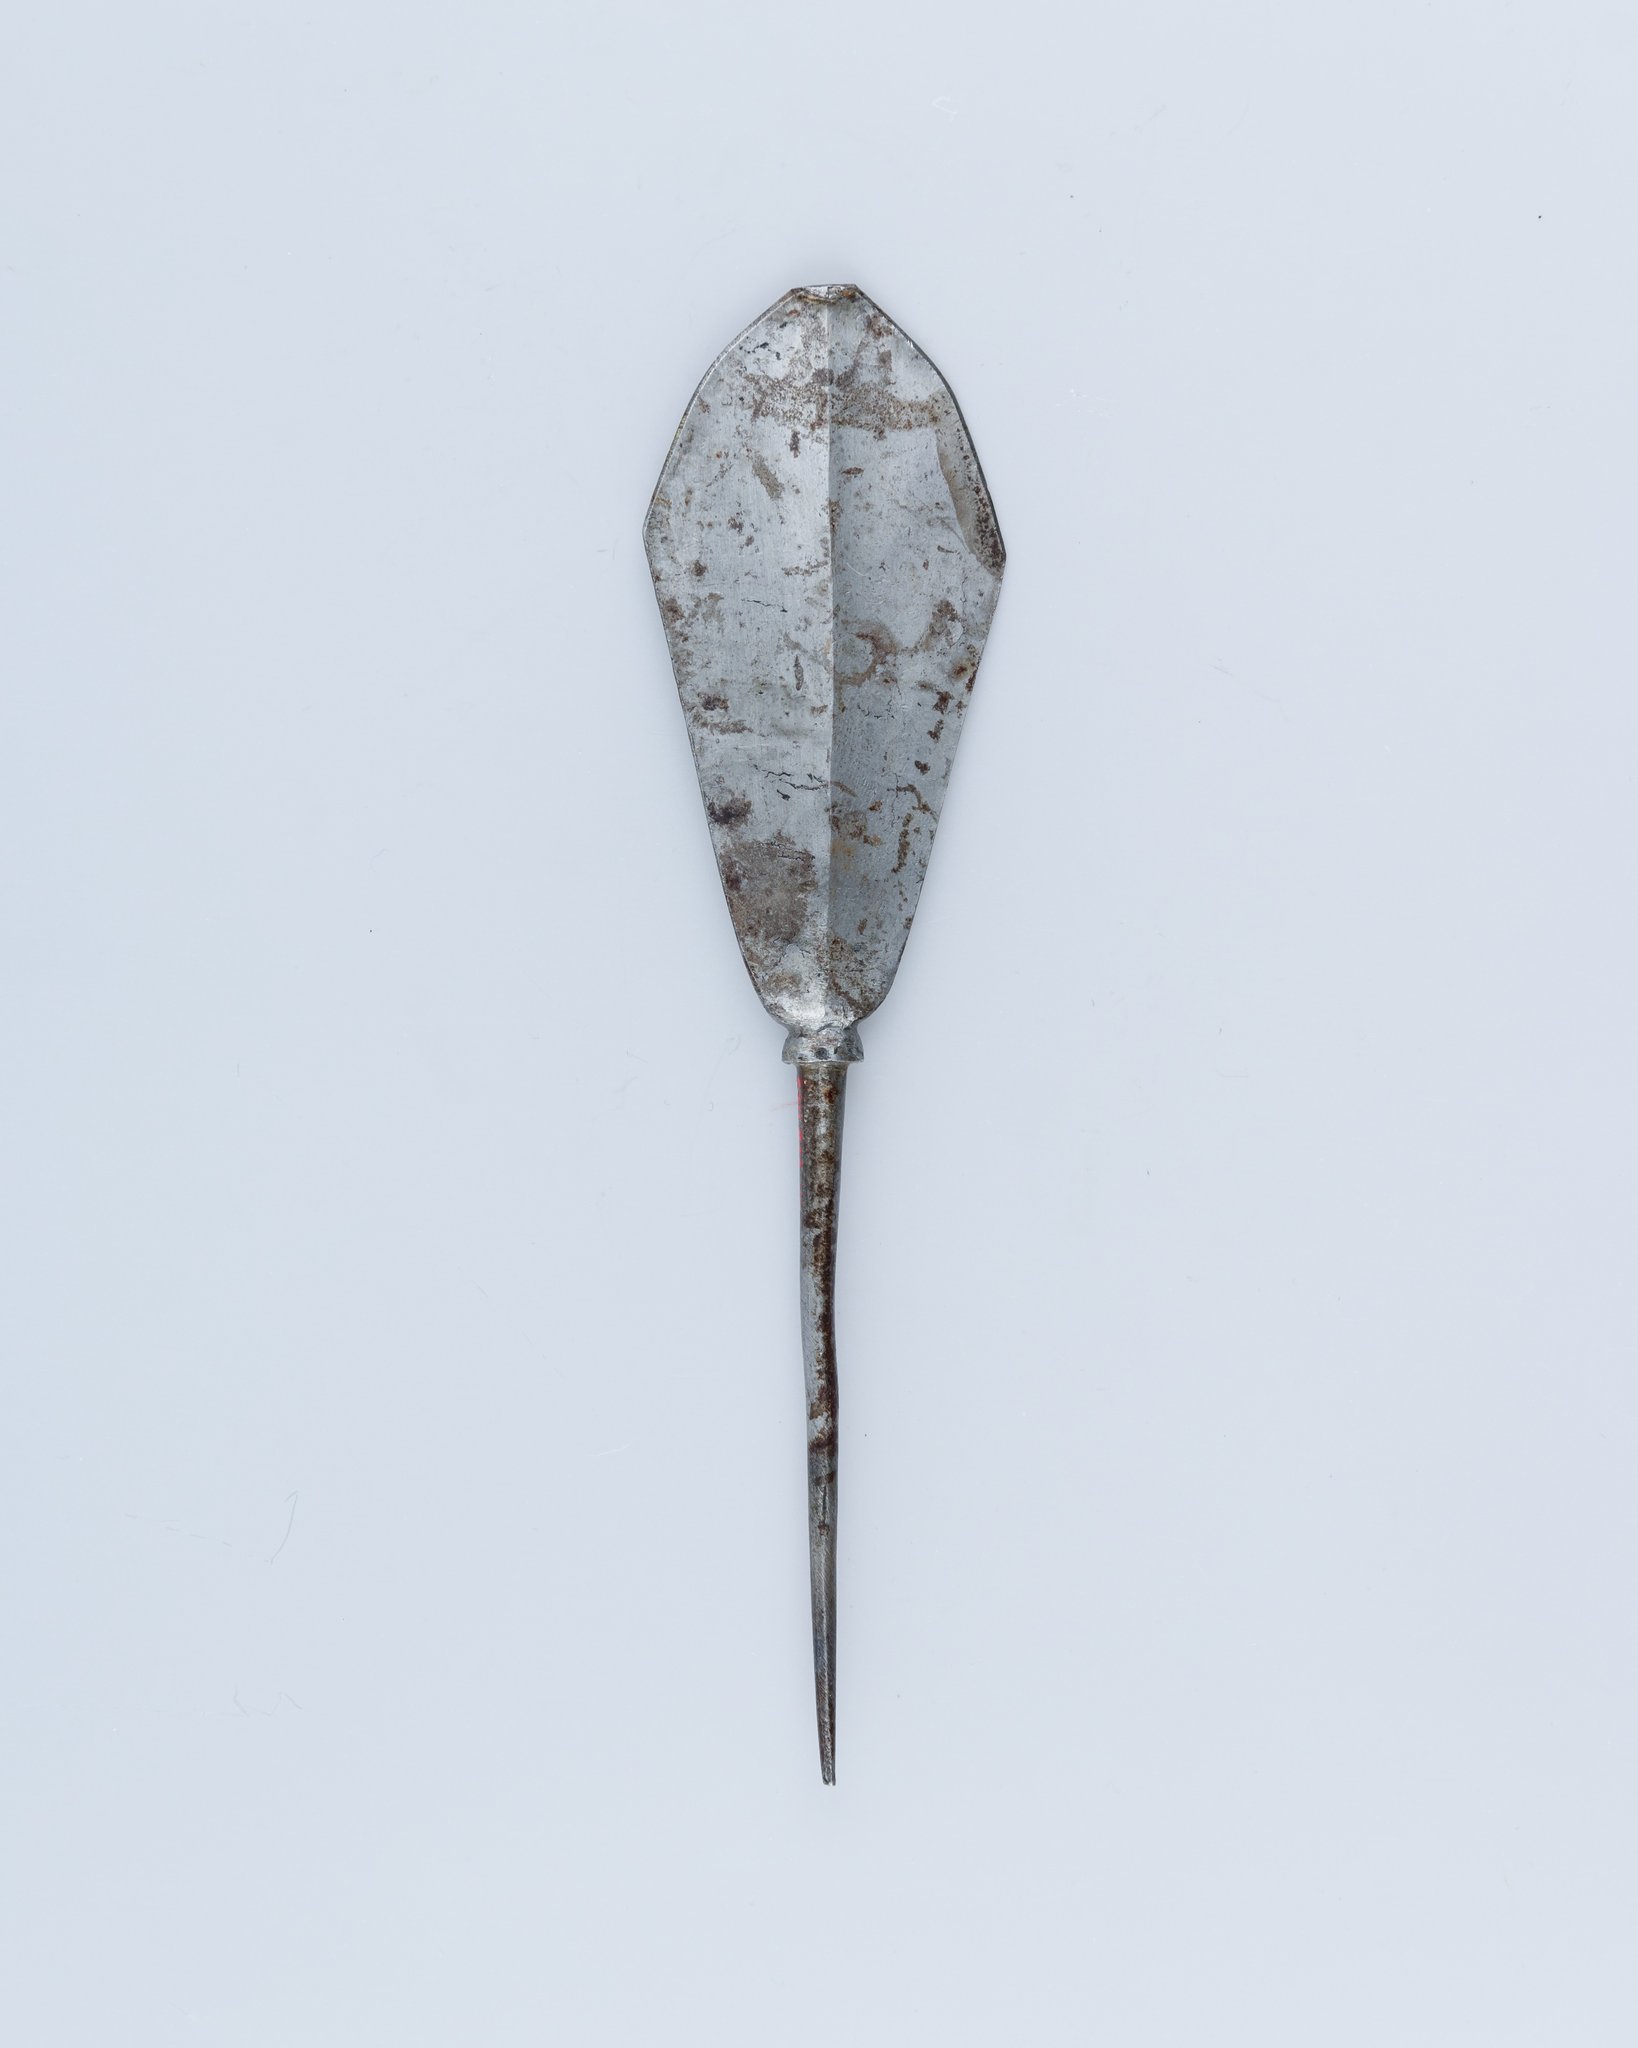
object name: arrowhead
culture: tibetan or chinese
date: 1701-1900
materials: iron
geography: china